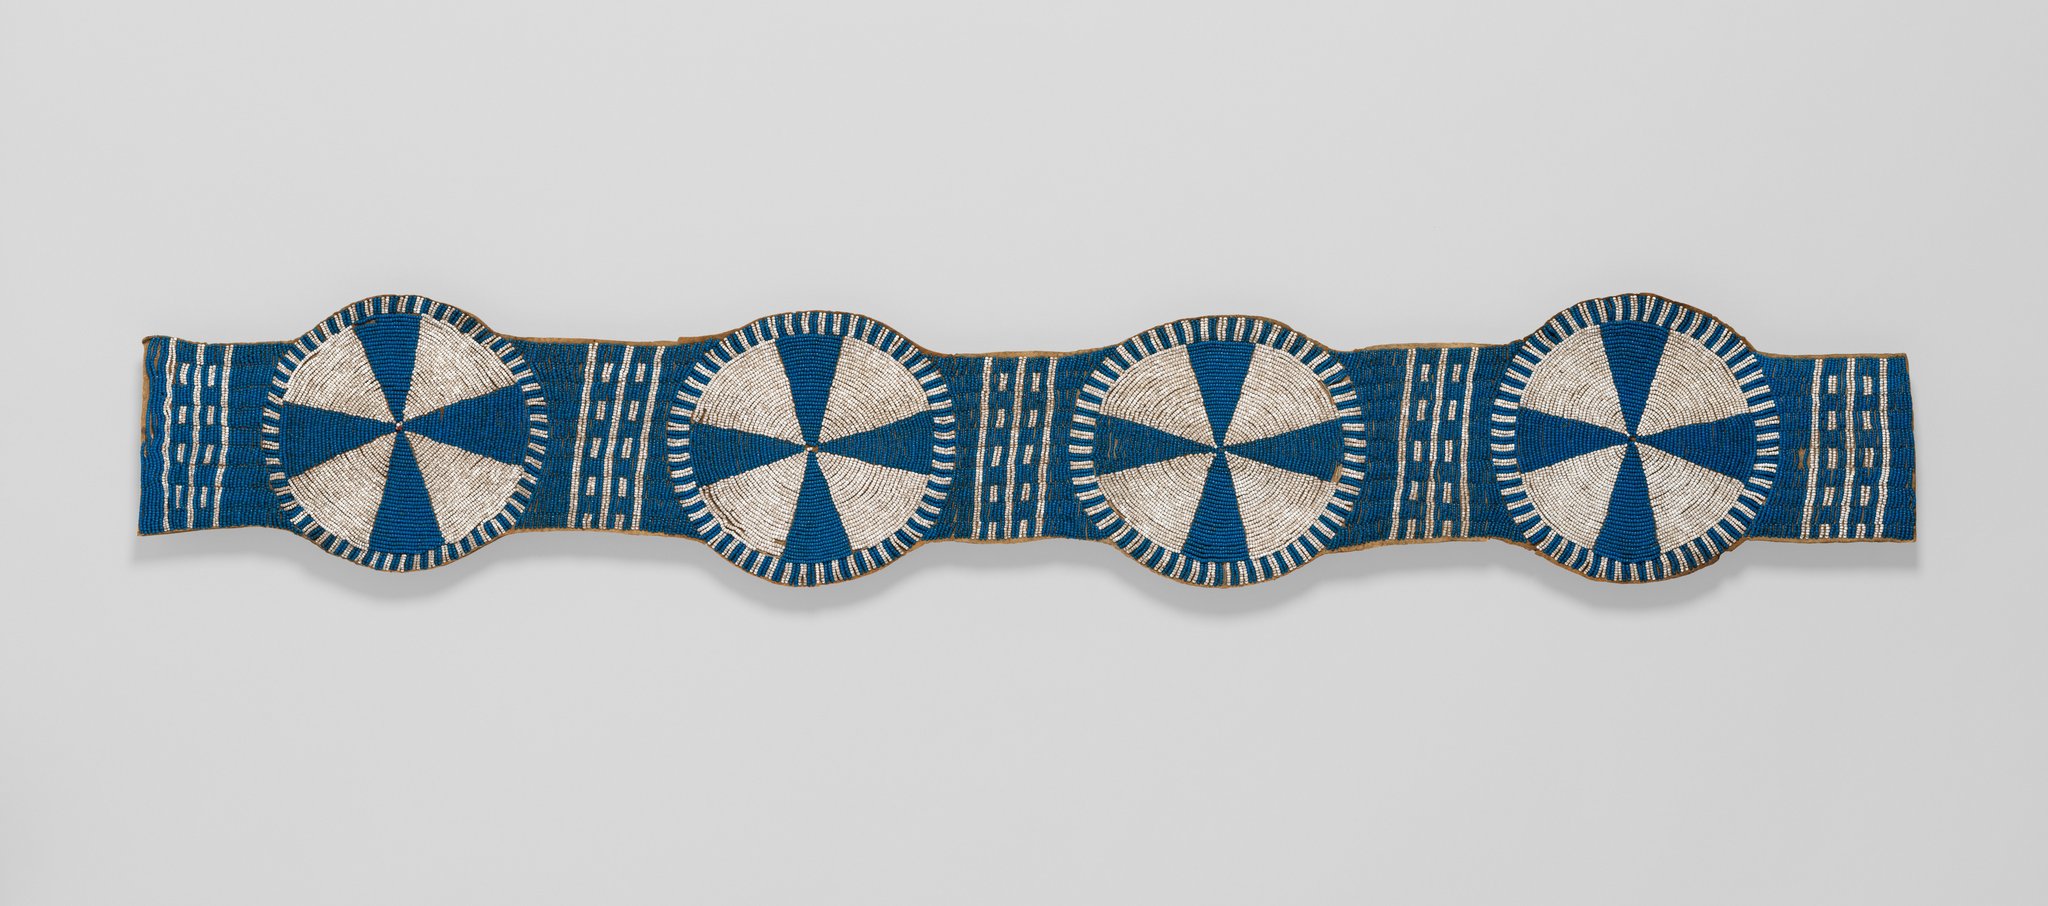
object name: blanket strip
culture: central plains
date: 1830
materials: glass, leather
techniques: tanning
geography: united states